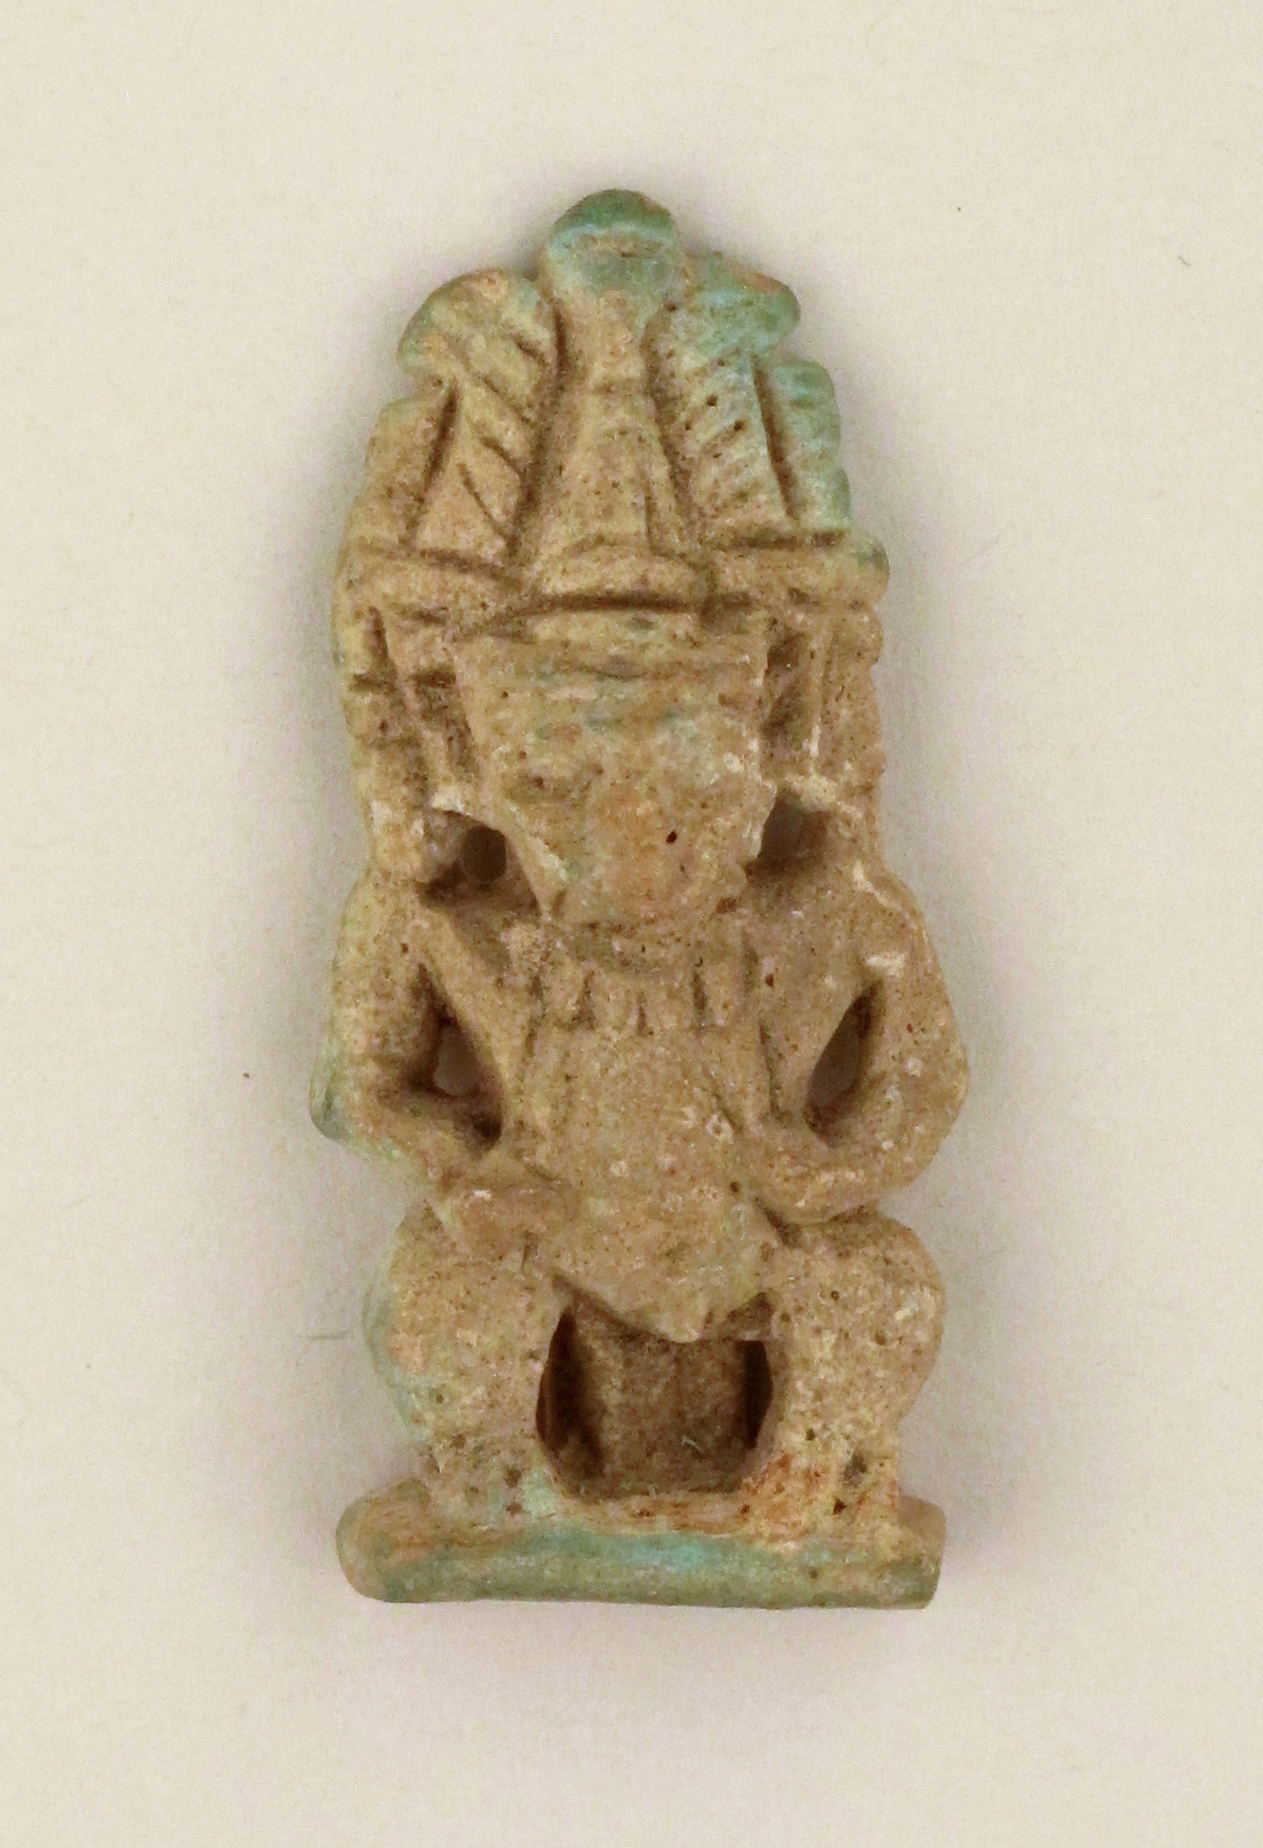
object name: amulet, khepera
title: Faience amulet in the form of the dwarf god Pataikos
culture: egyptian, ptolemaic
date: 664-630 BCE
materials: faience